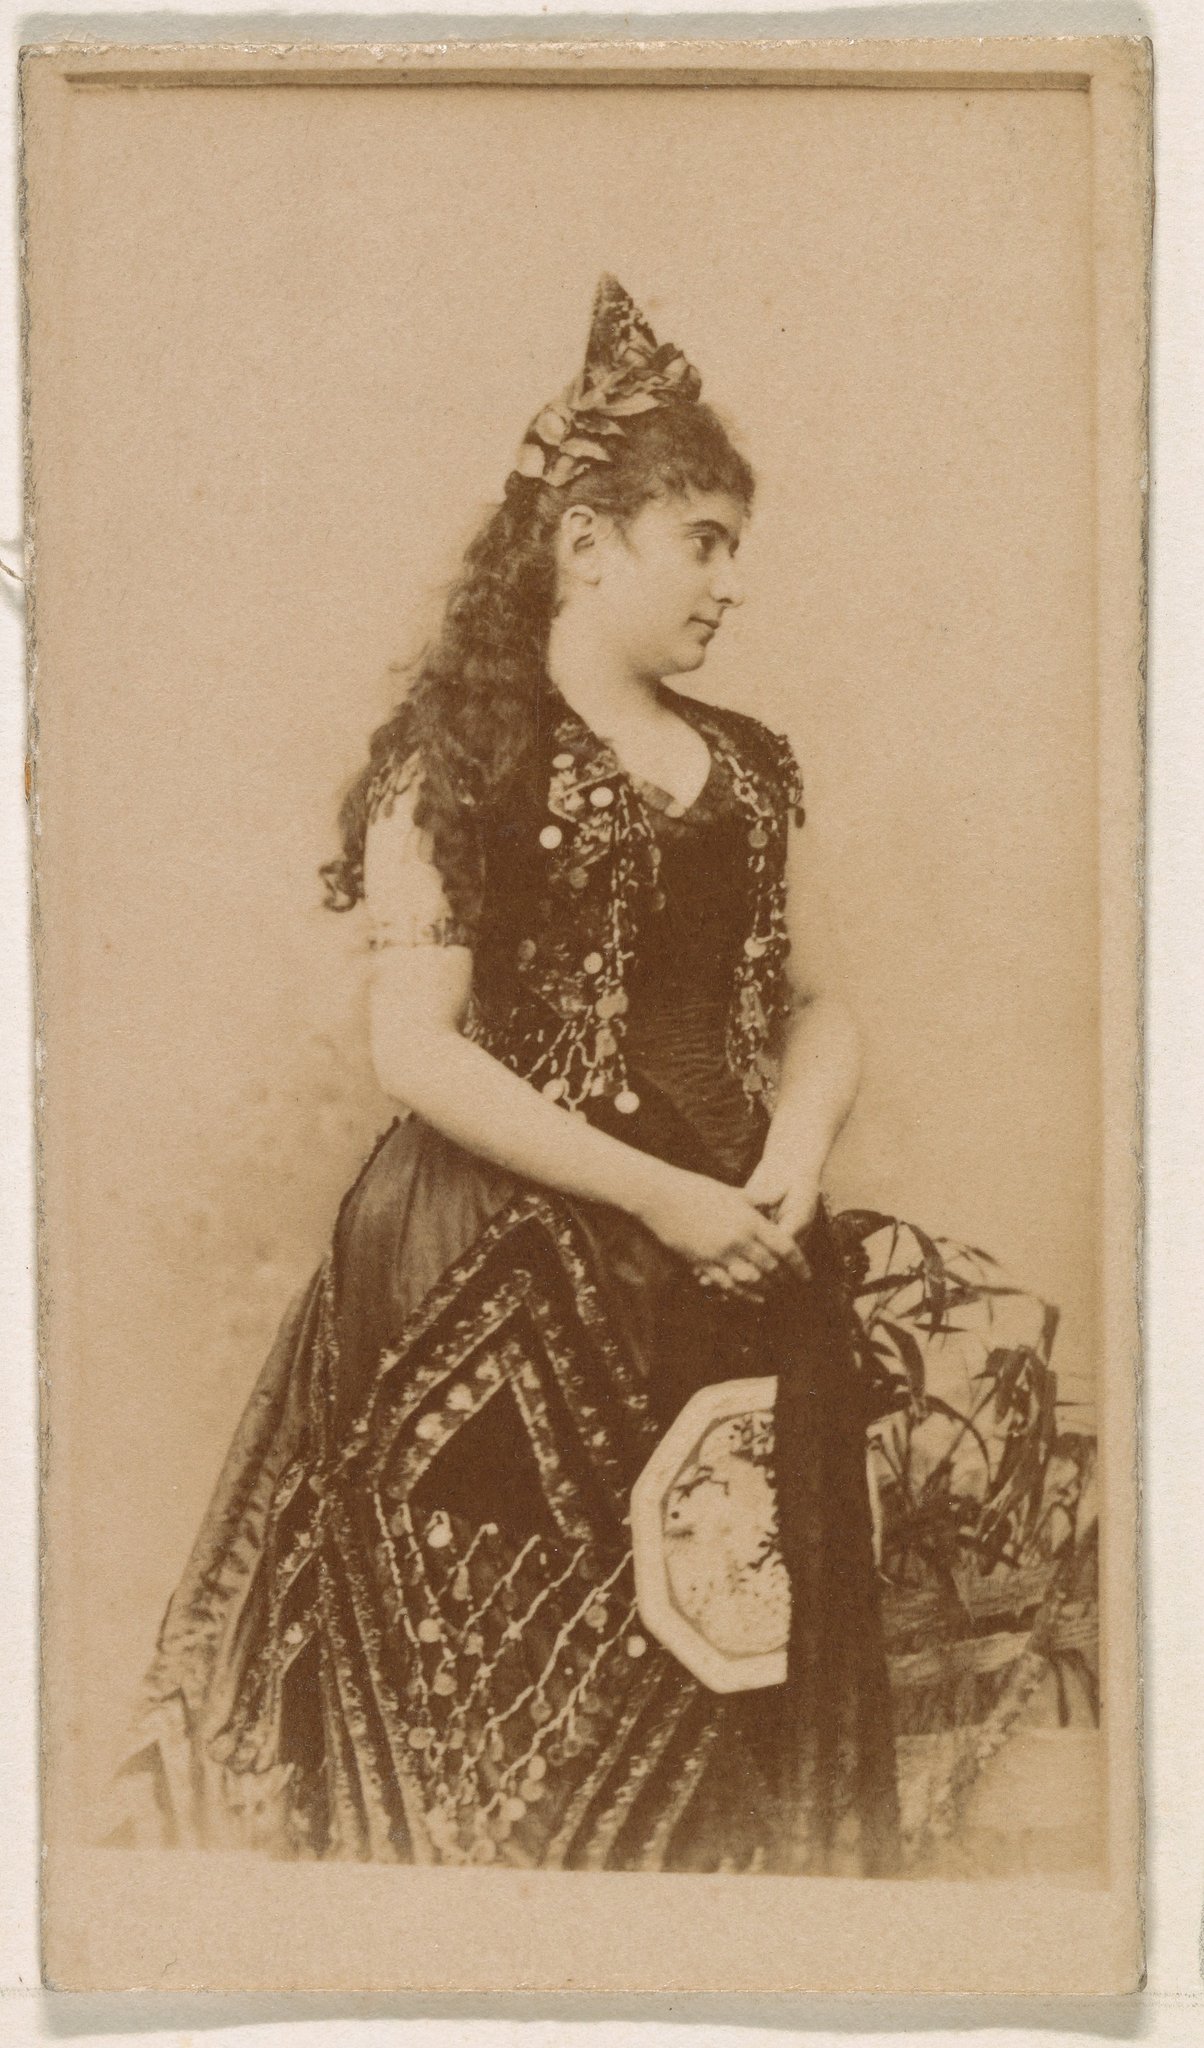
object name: photograph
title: Actress in long dark gown, from the Actresses series (N245) issued by Kinney Brothers to promote Sweet Caporal Cigarettes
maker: kinney brothers tobacco company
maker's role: publisher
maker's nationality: american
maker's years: 1869-2011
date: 1890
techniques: albumen silver print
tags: women,actresses